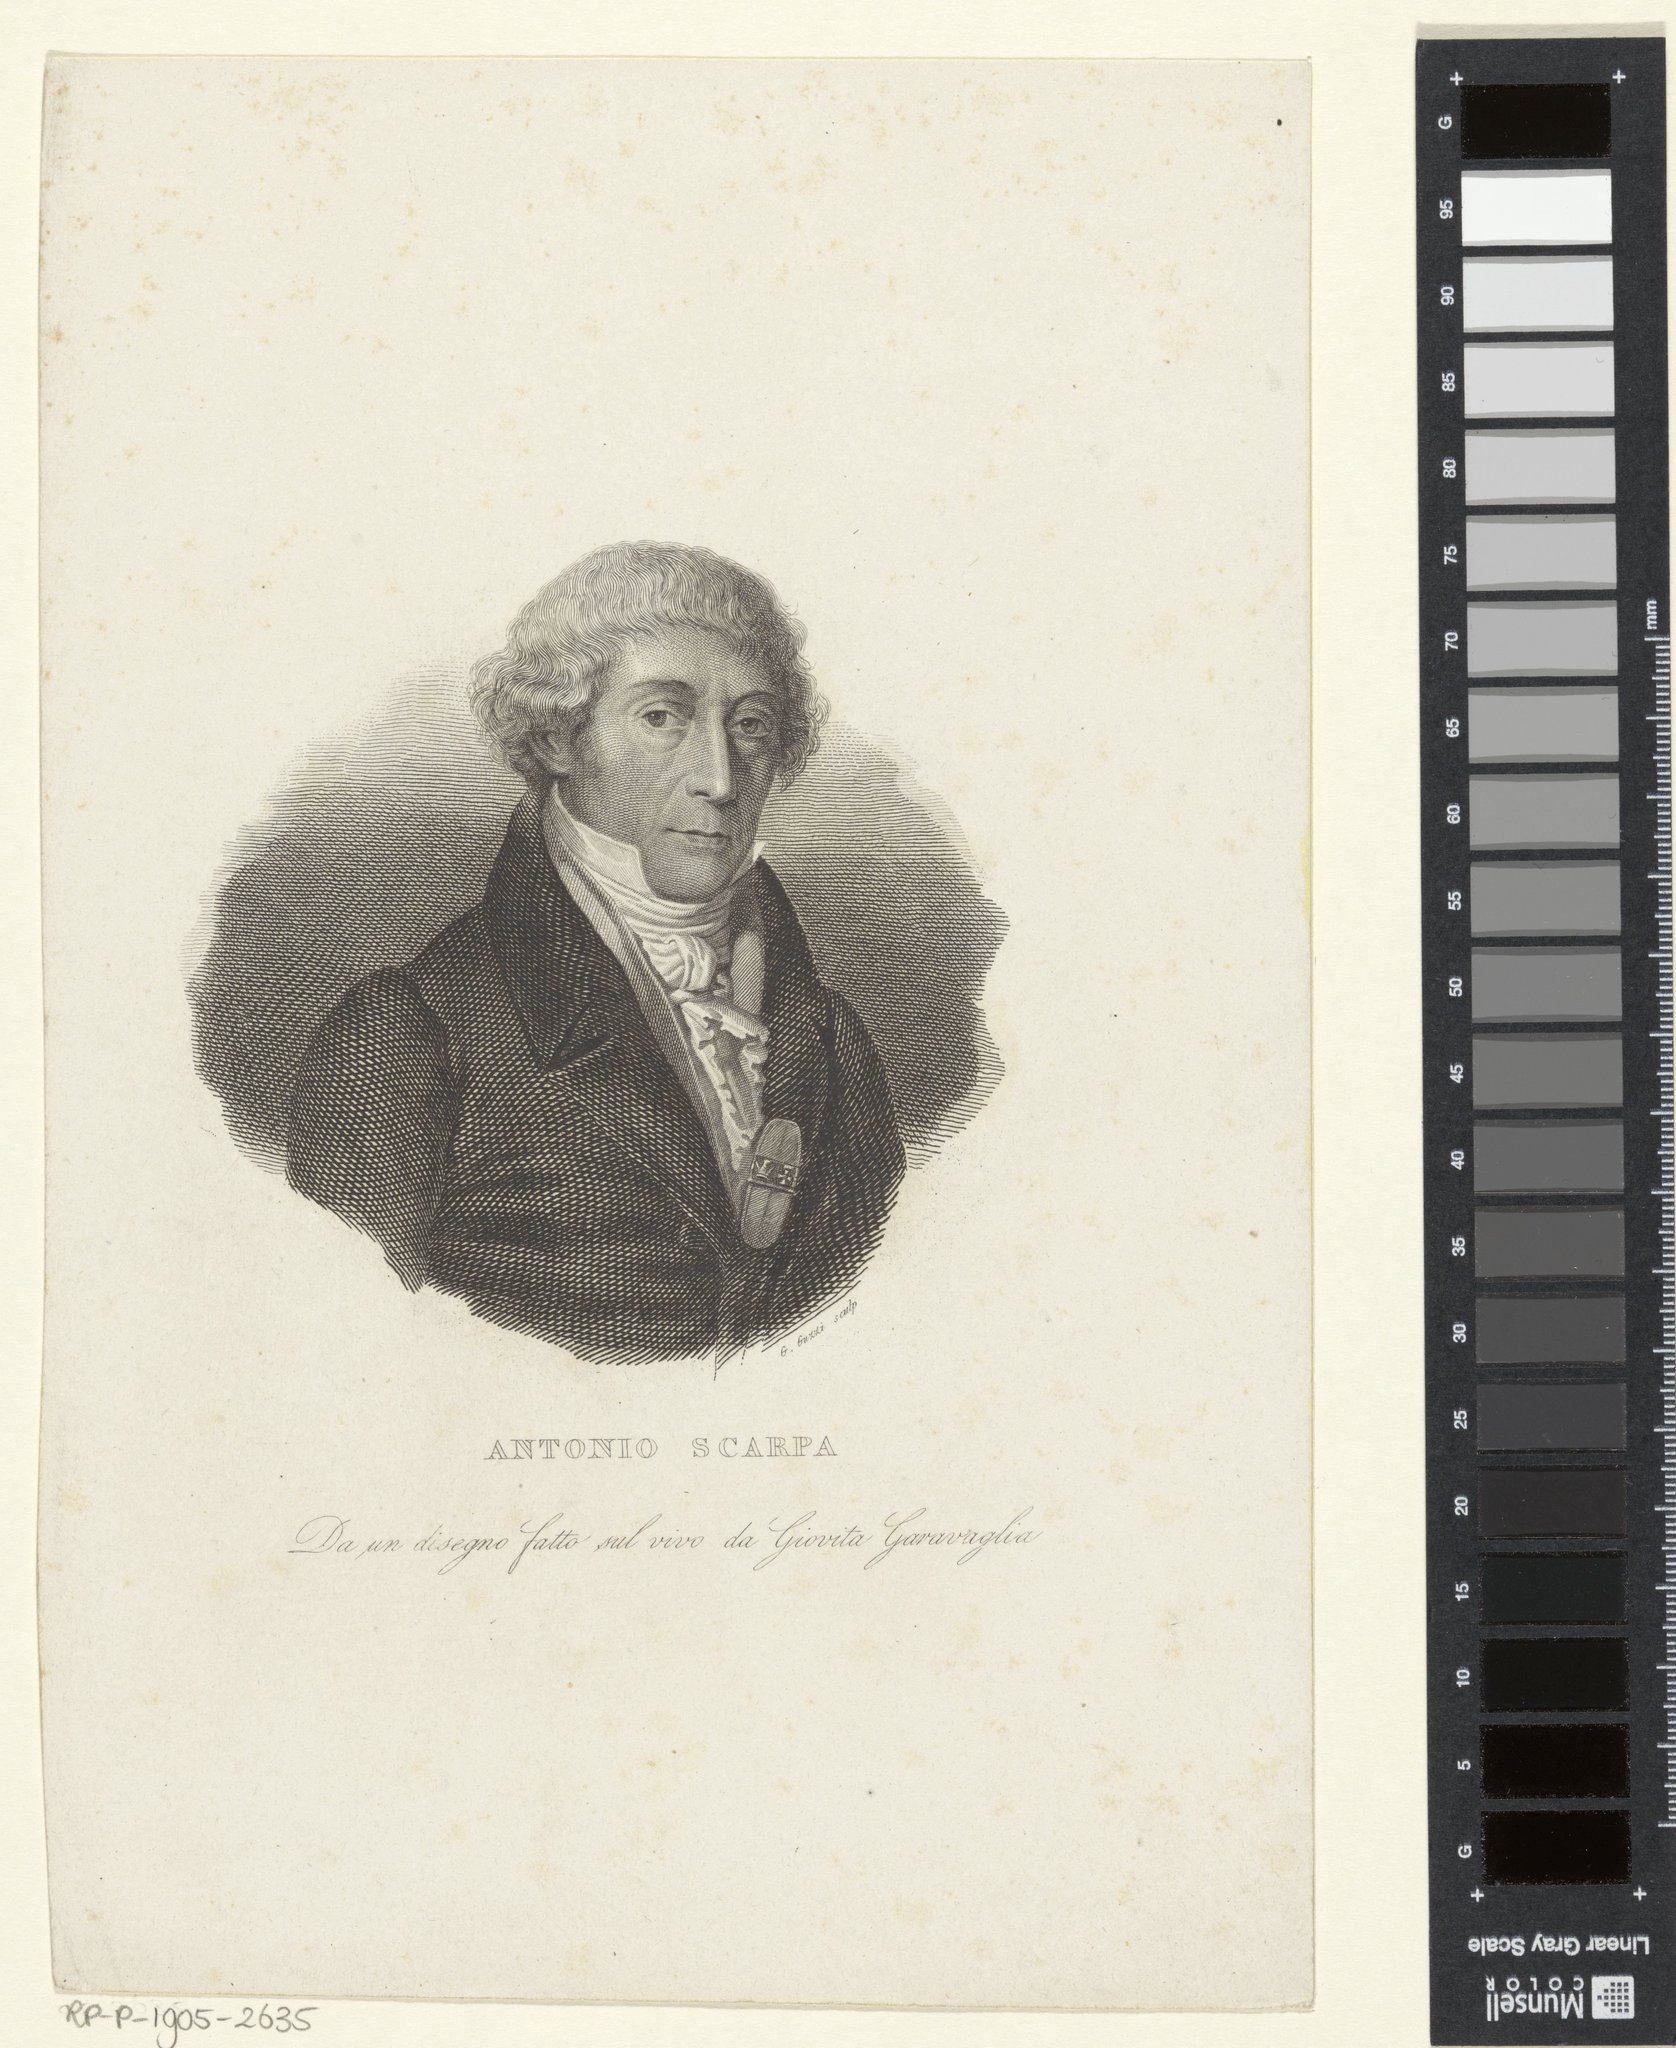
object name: print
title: Portret van anatomist Antonio Scarpa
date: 1834-1842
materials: paper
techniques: engraving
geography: italy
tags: historical persons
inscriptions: collector's mark: Lugt 2228